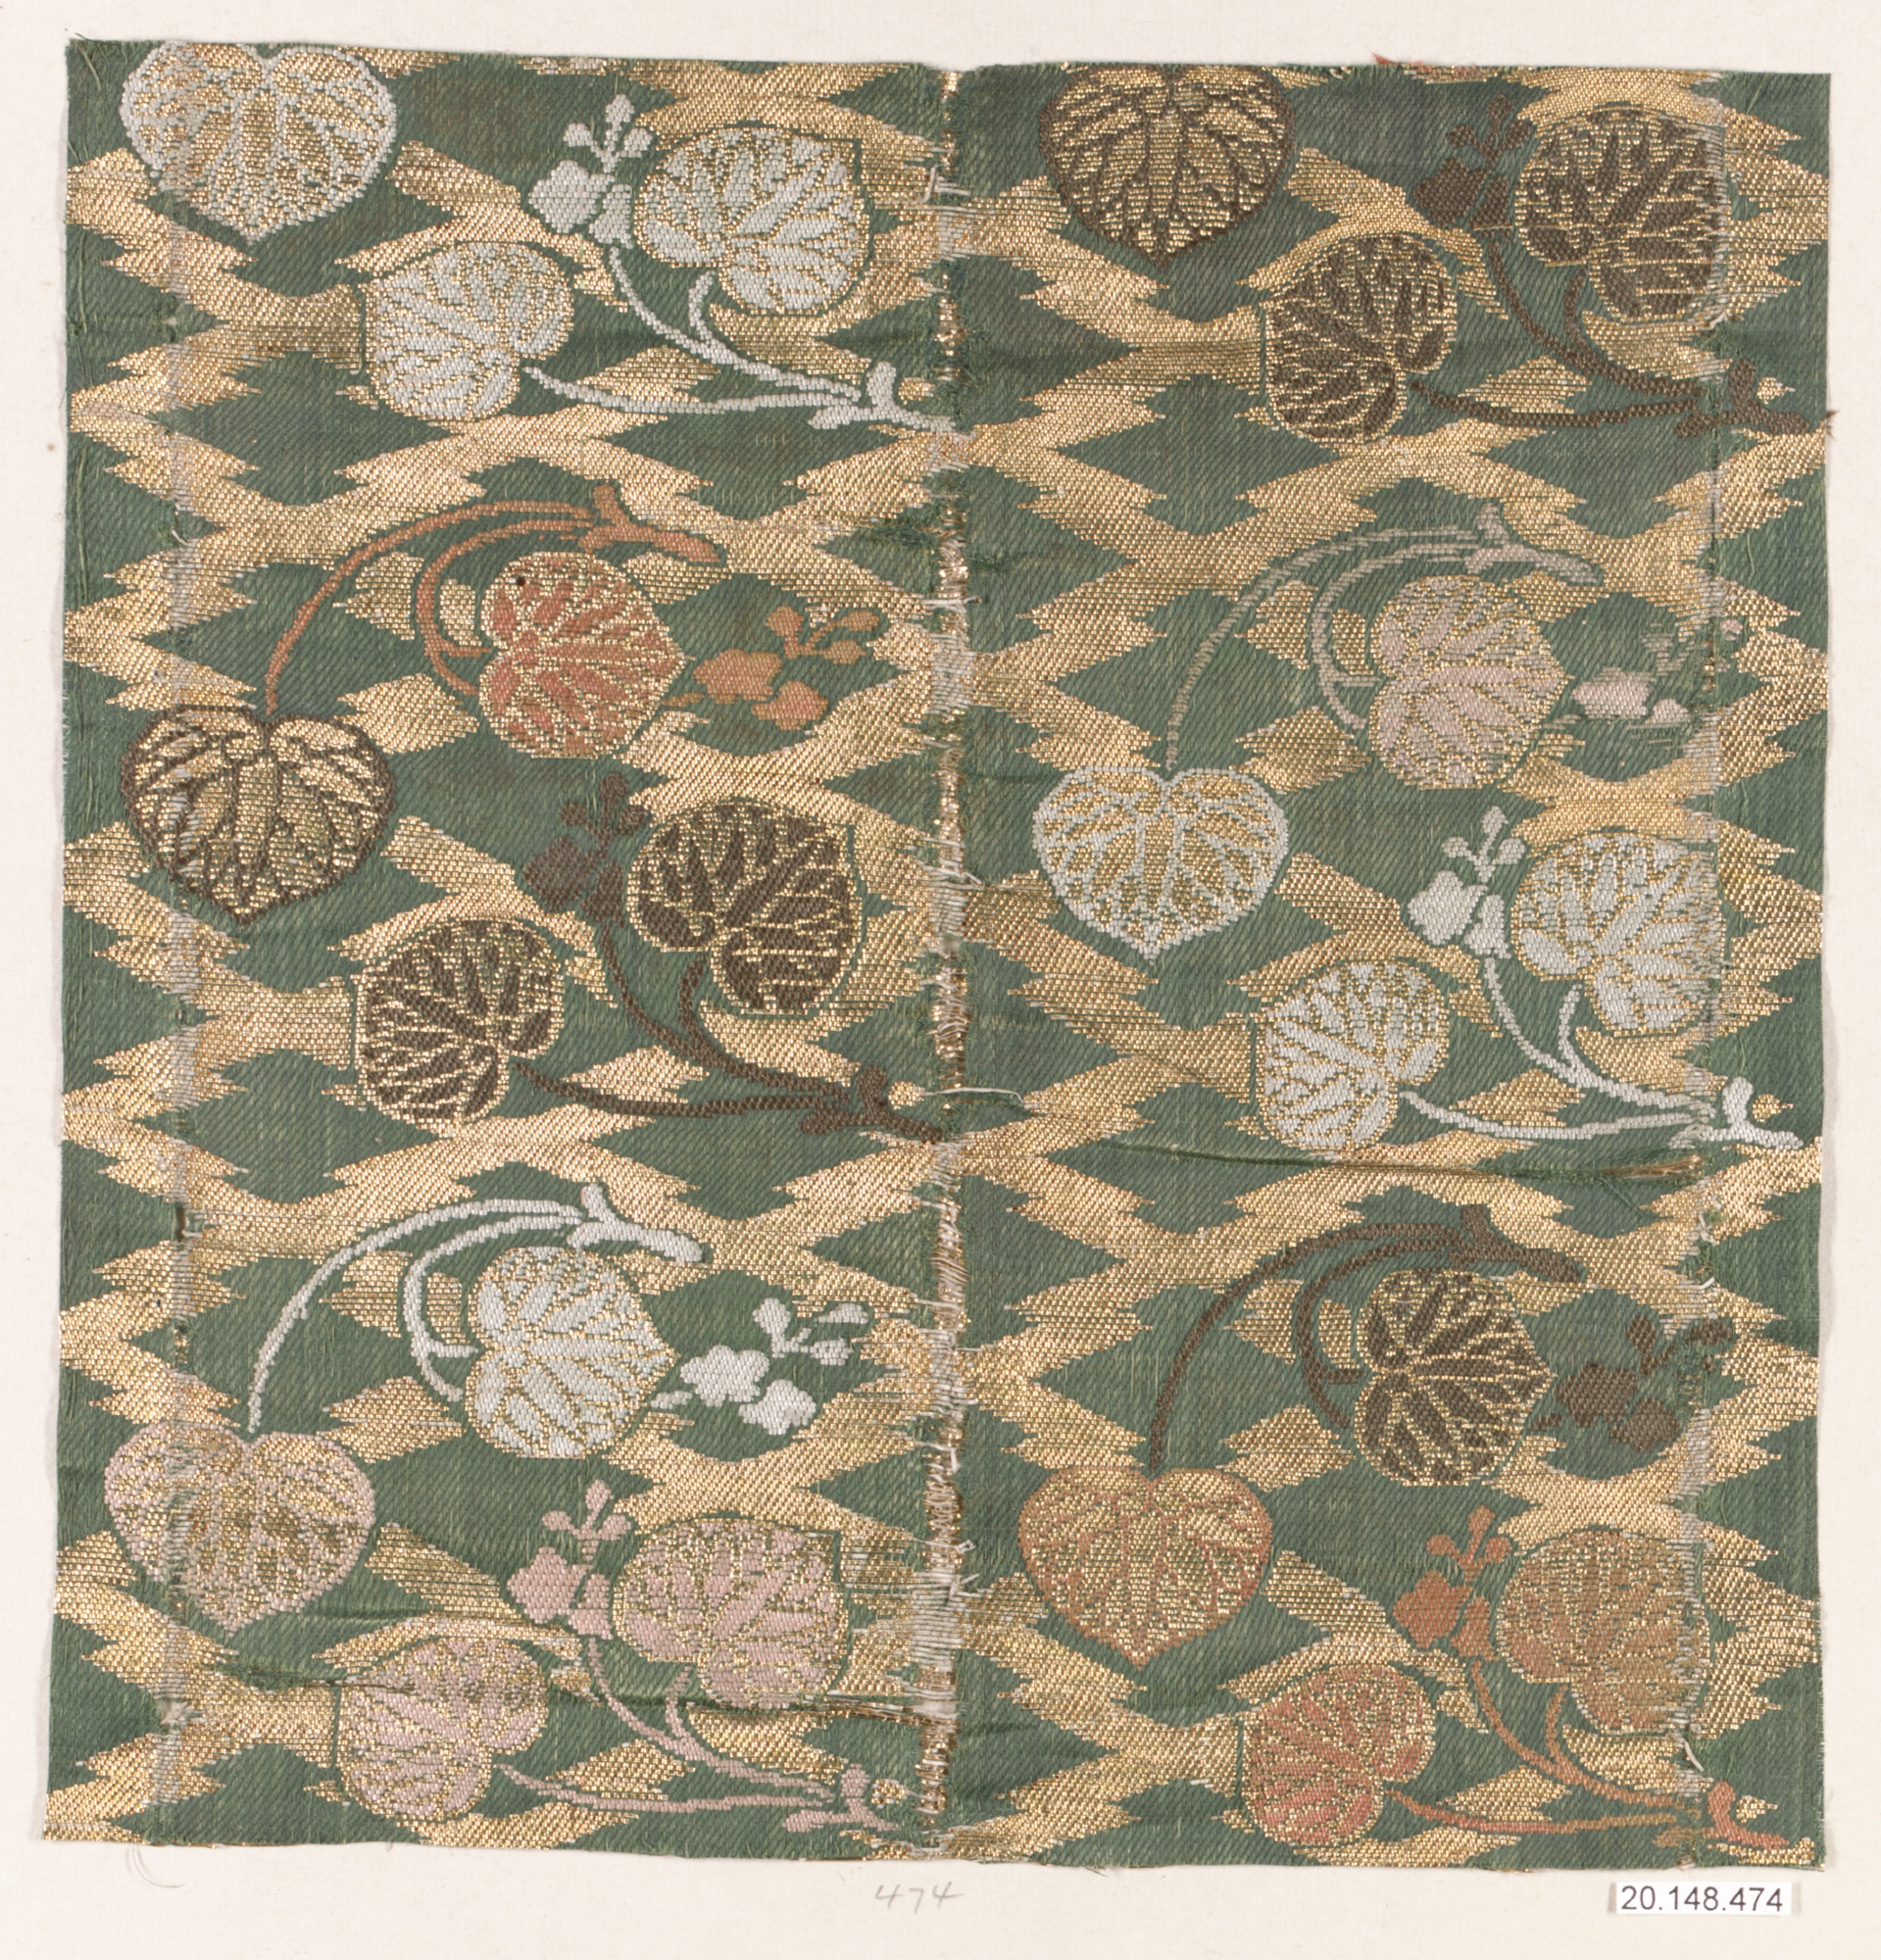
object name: piece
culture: japanese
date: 1601-1700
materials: silk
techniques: compound weave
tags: leaves